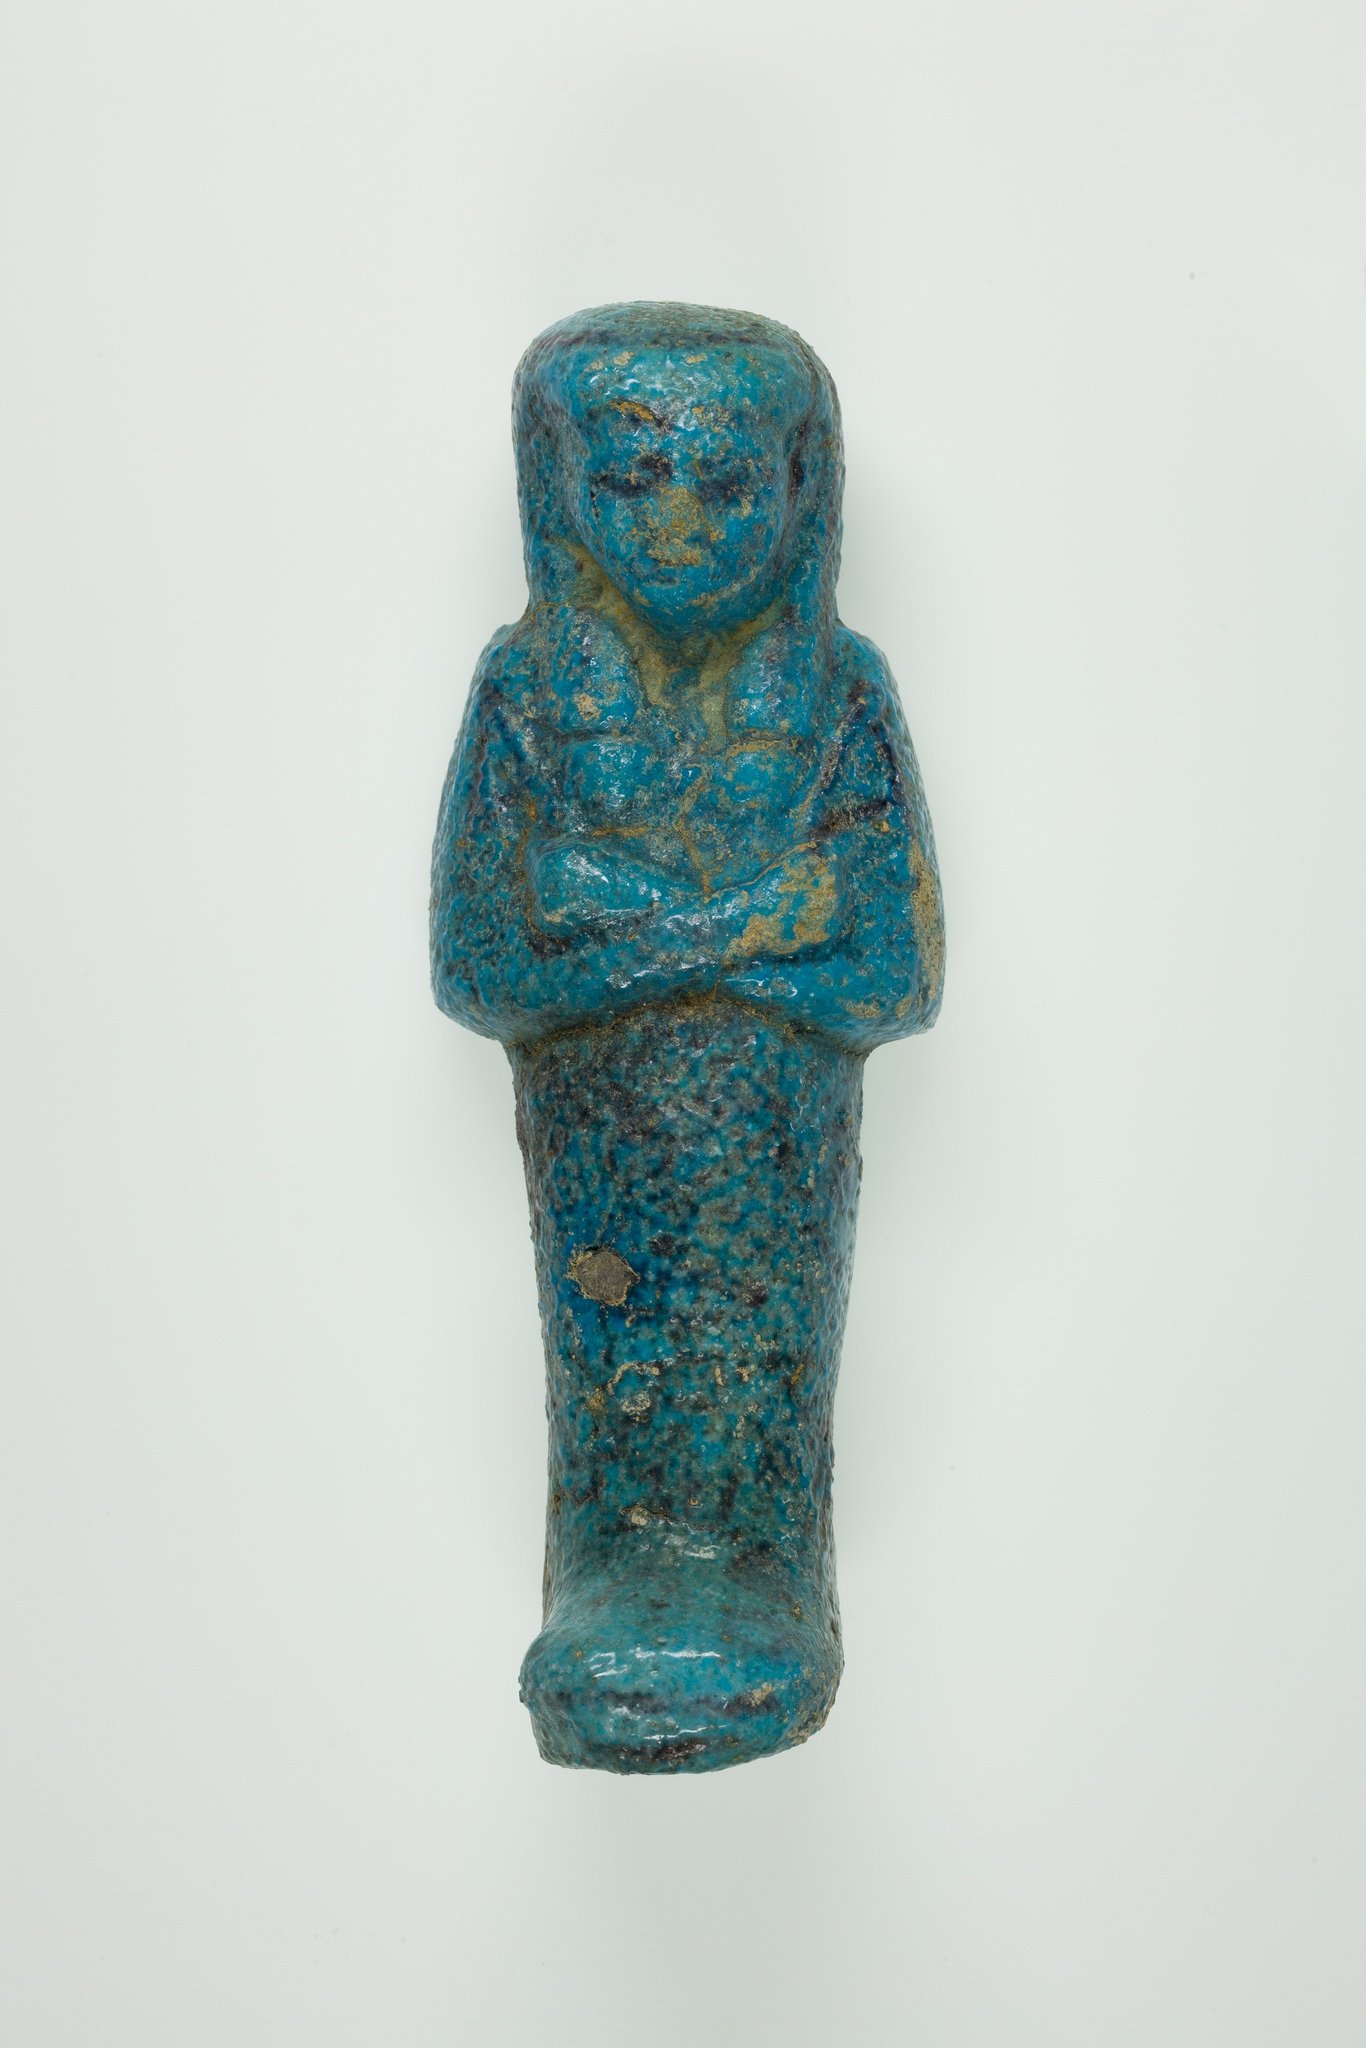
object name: worker shabti, henettawy c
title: Worker Shabti of Henettawy (C), Daughter of Isetemkheb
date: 990-970 BCE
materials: faience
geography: egypt